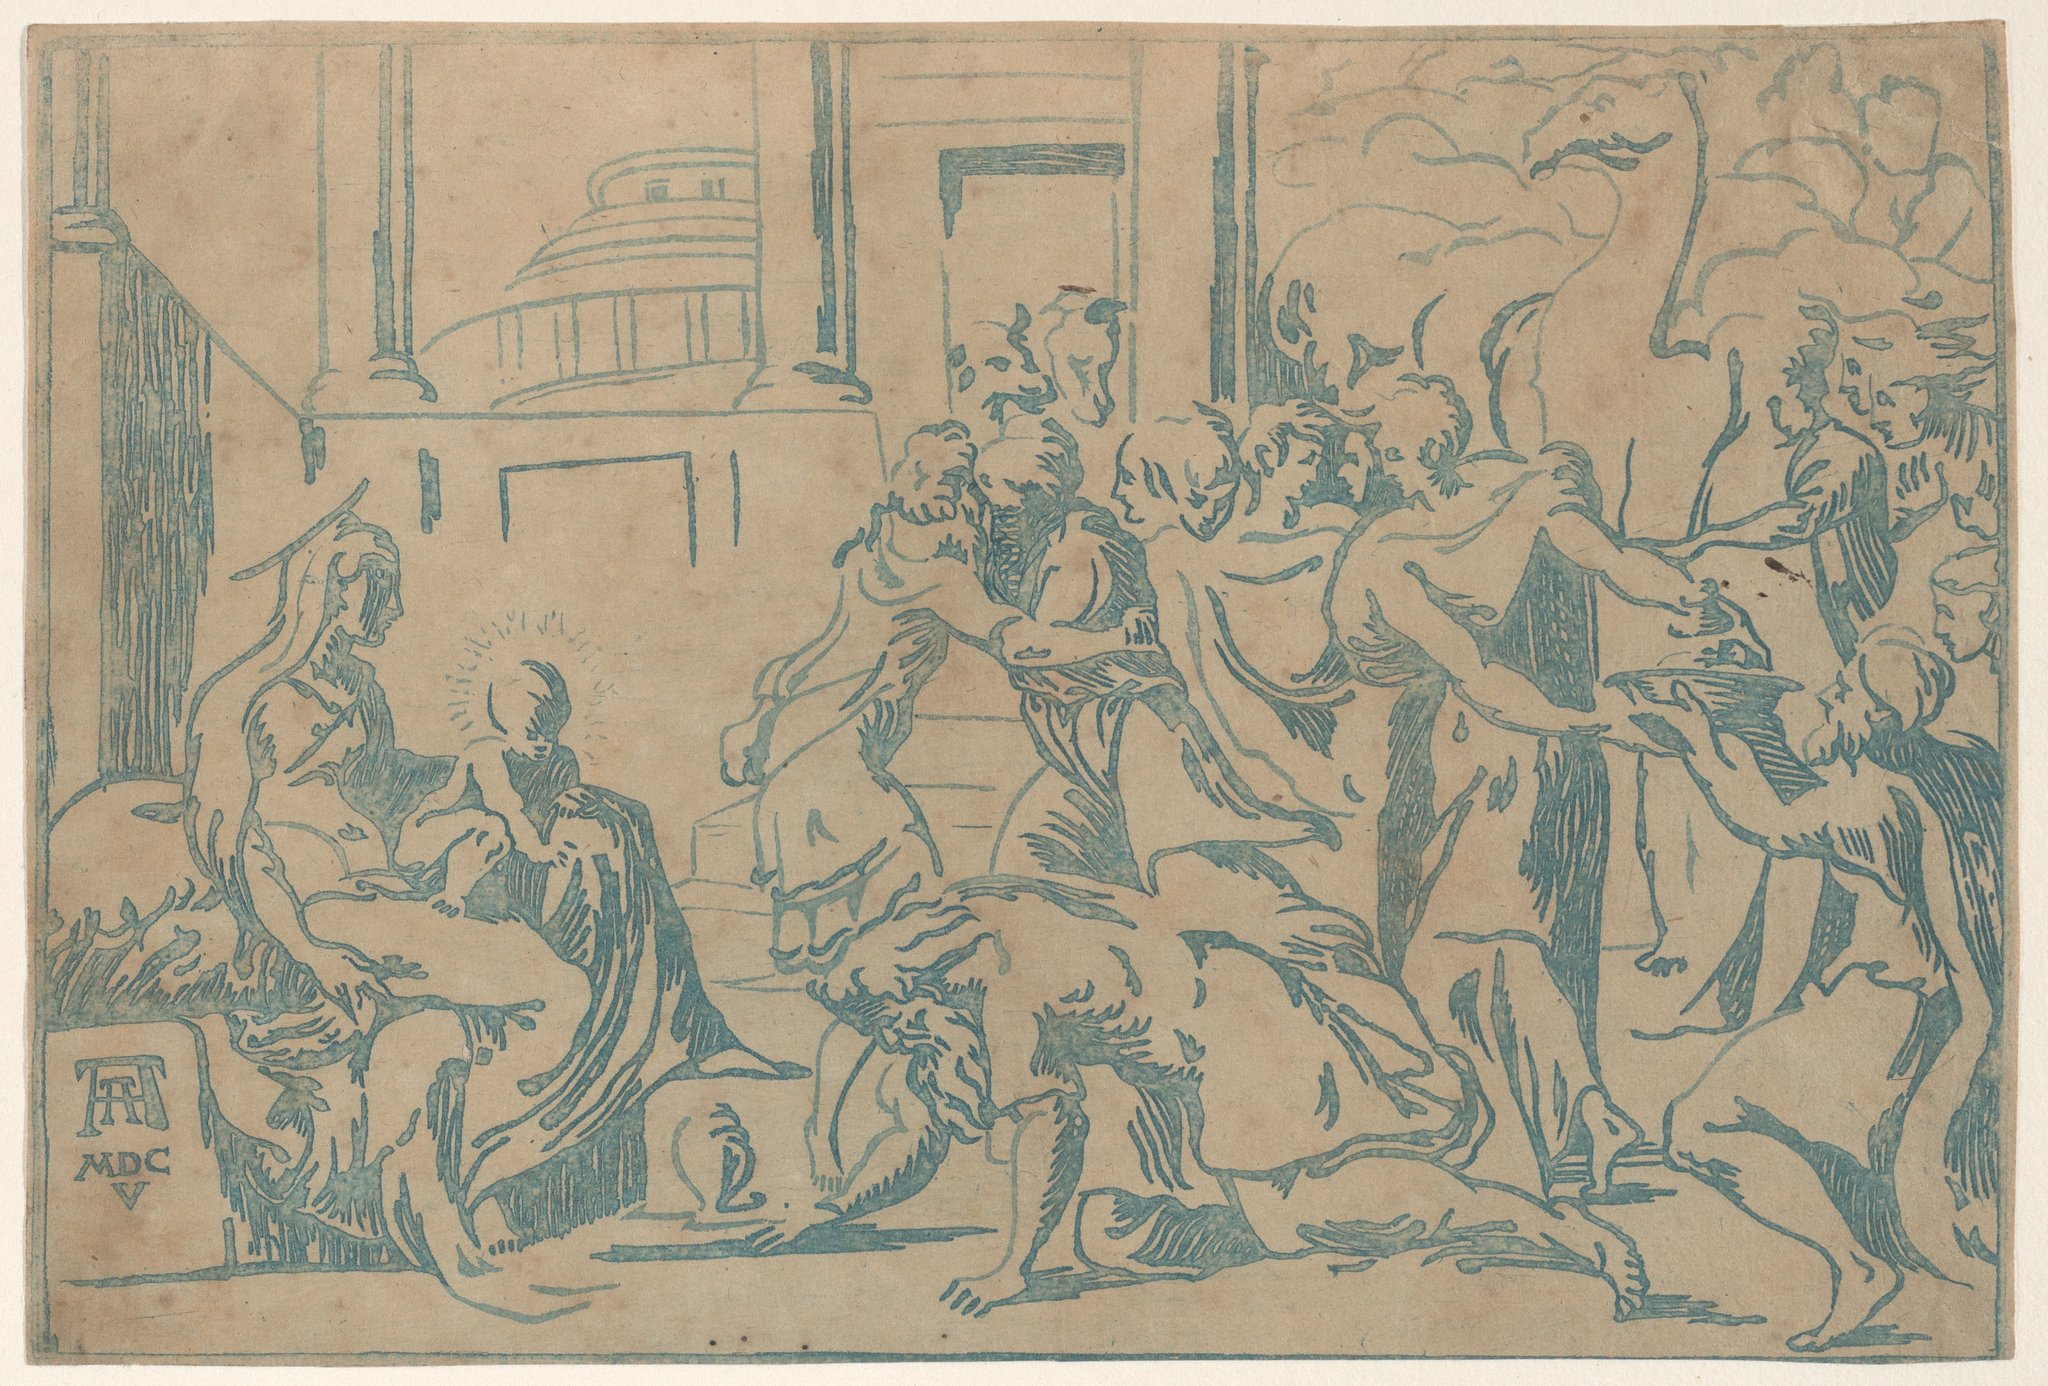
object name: print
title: The Adoration of the Magi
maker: niccolò vicentino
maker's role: artist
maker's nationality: italian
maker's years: 1510-1550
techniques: printing, woodcut